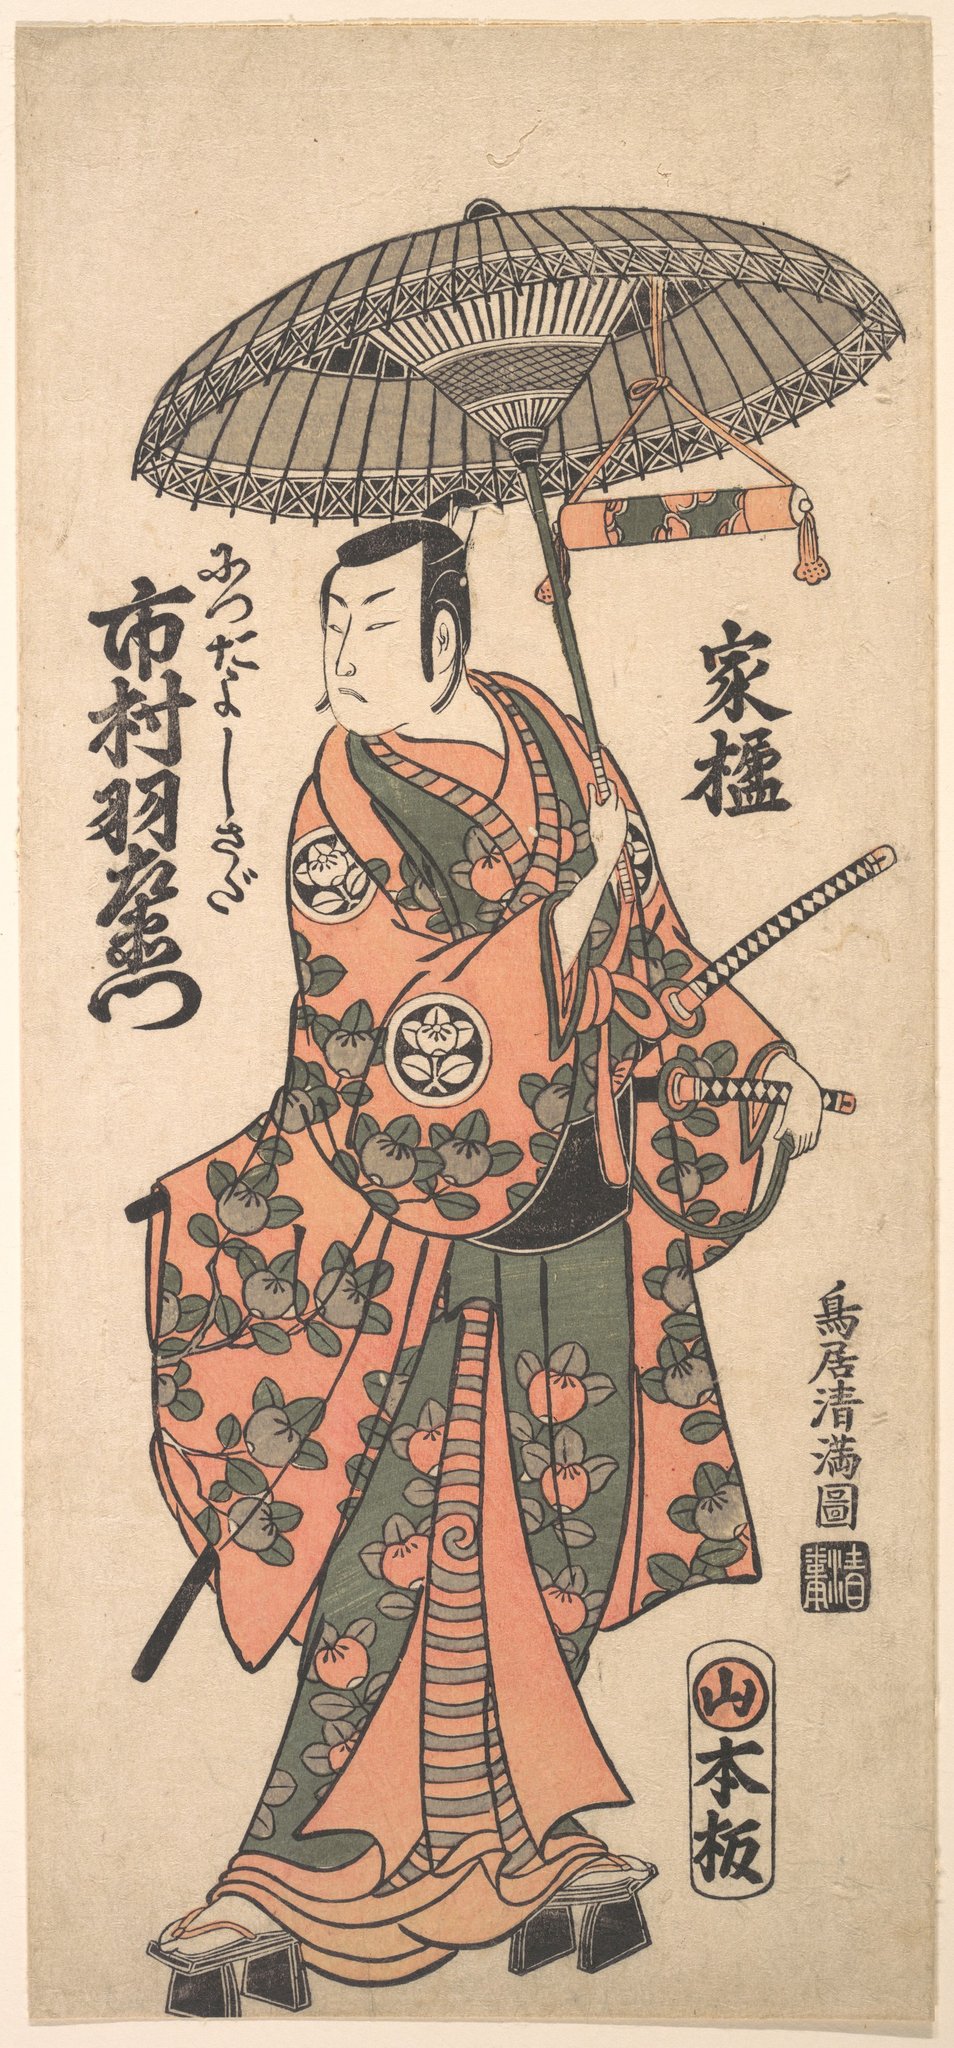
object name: woodblock print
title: Kabuki Actor Ichimura Uzaemon IX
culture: japanese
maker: torii kiyomitsu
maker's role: artist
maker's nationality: japanese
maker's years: 1735-1785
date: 1759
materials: ink, paper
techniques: woodblock print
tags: men,actors,umbrellas